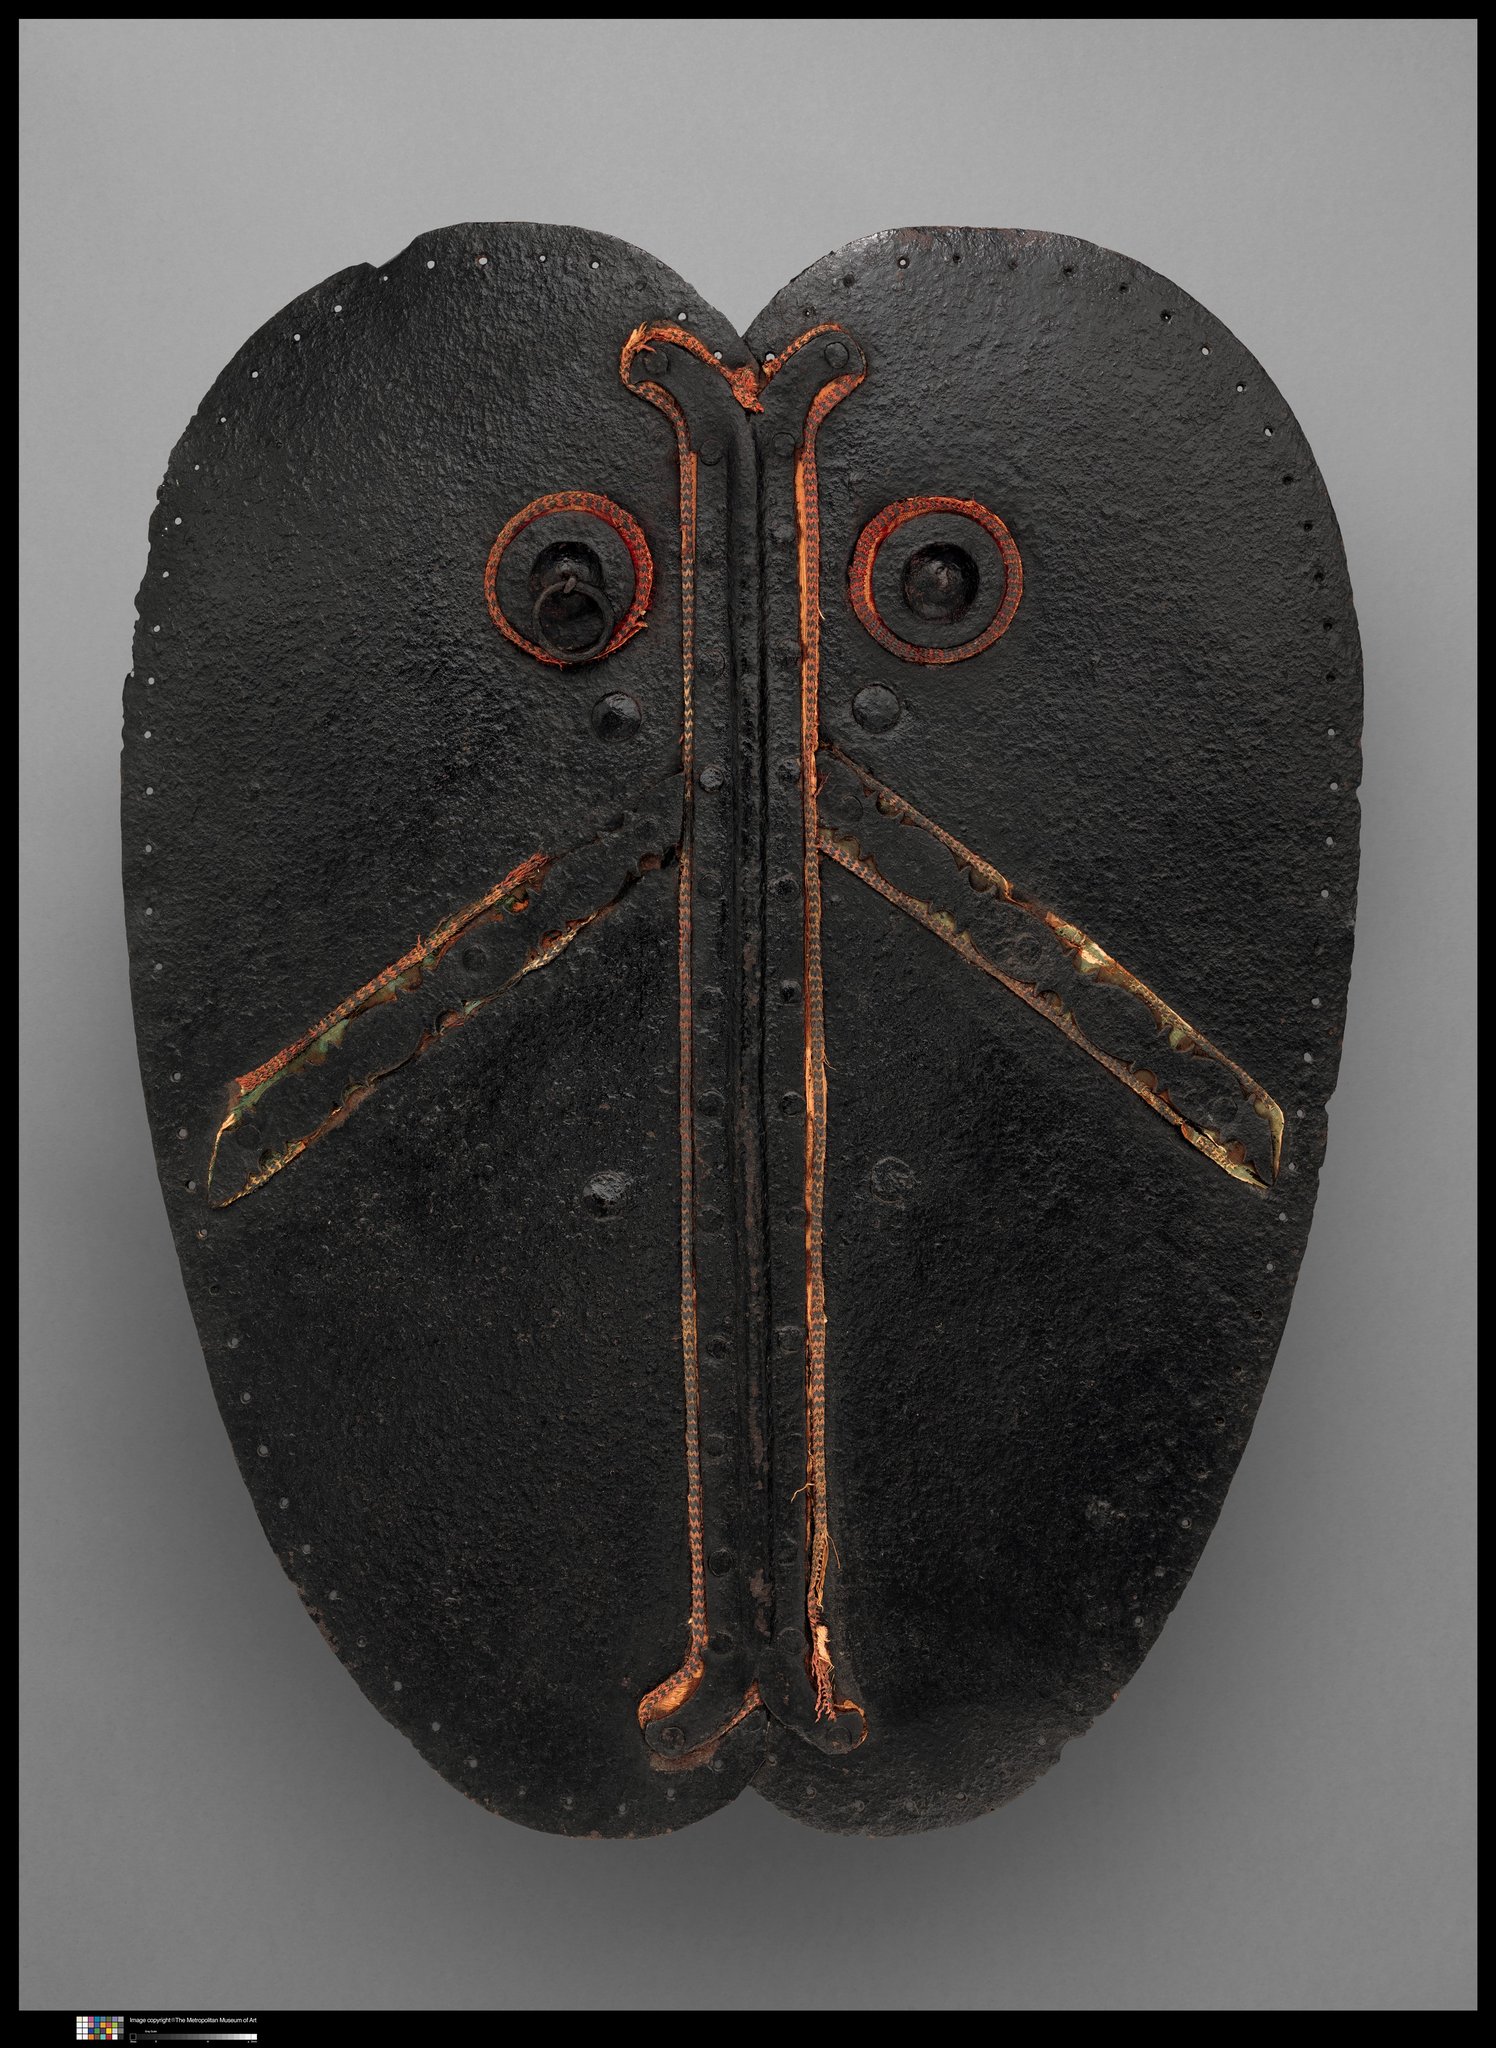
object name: shield adarga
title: Shield (Adarga)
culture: spanish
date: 1500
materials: iron, textile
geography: spain